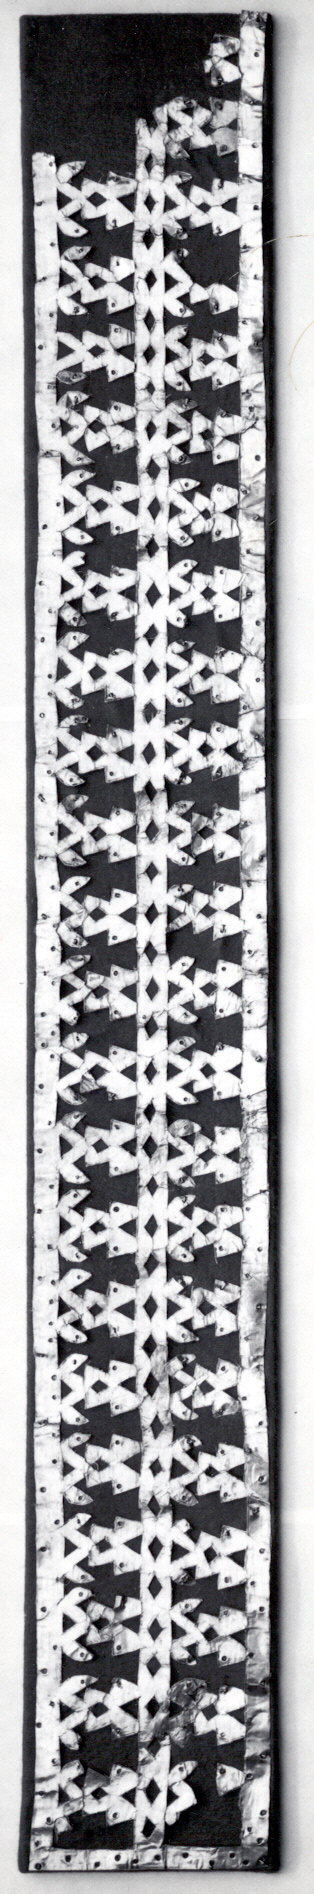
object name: head ornament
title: Headband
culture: inca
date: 1401-1600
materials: gold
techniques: hammering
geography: peru